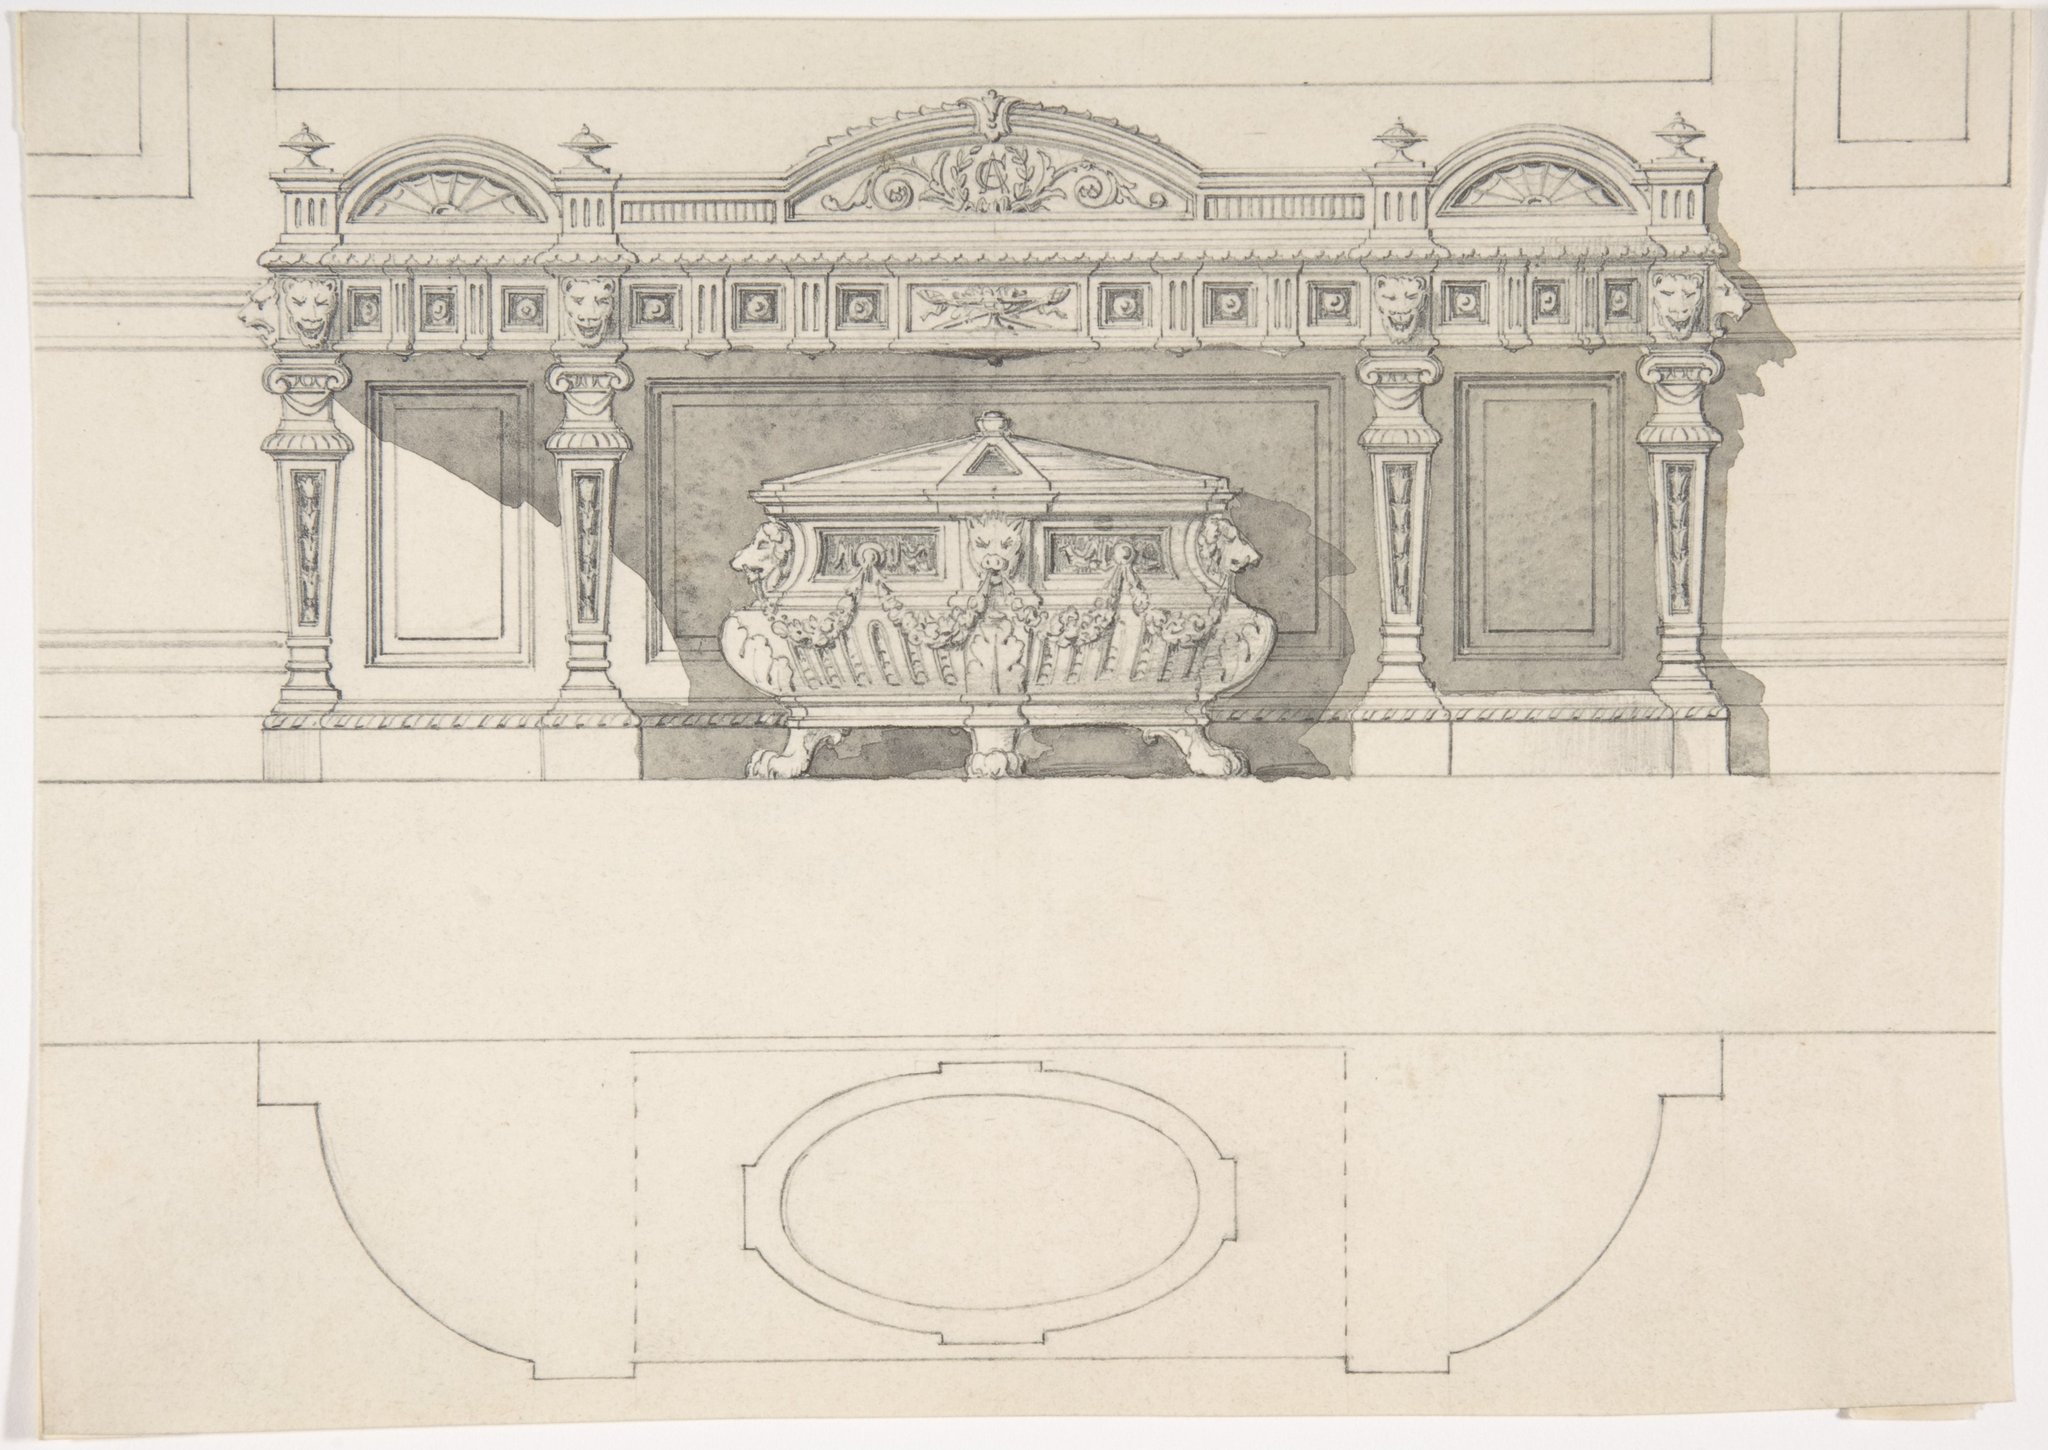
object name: drawing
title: Free Standing Tomb and Canopy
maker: anonymous, british, 19th century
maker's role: artist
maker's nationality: british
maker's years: 1800-1900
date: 1851-1900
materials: ink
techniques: brush, pen, wash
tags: tombs